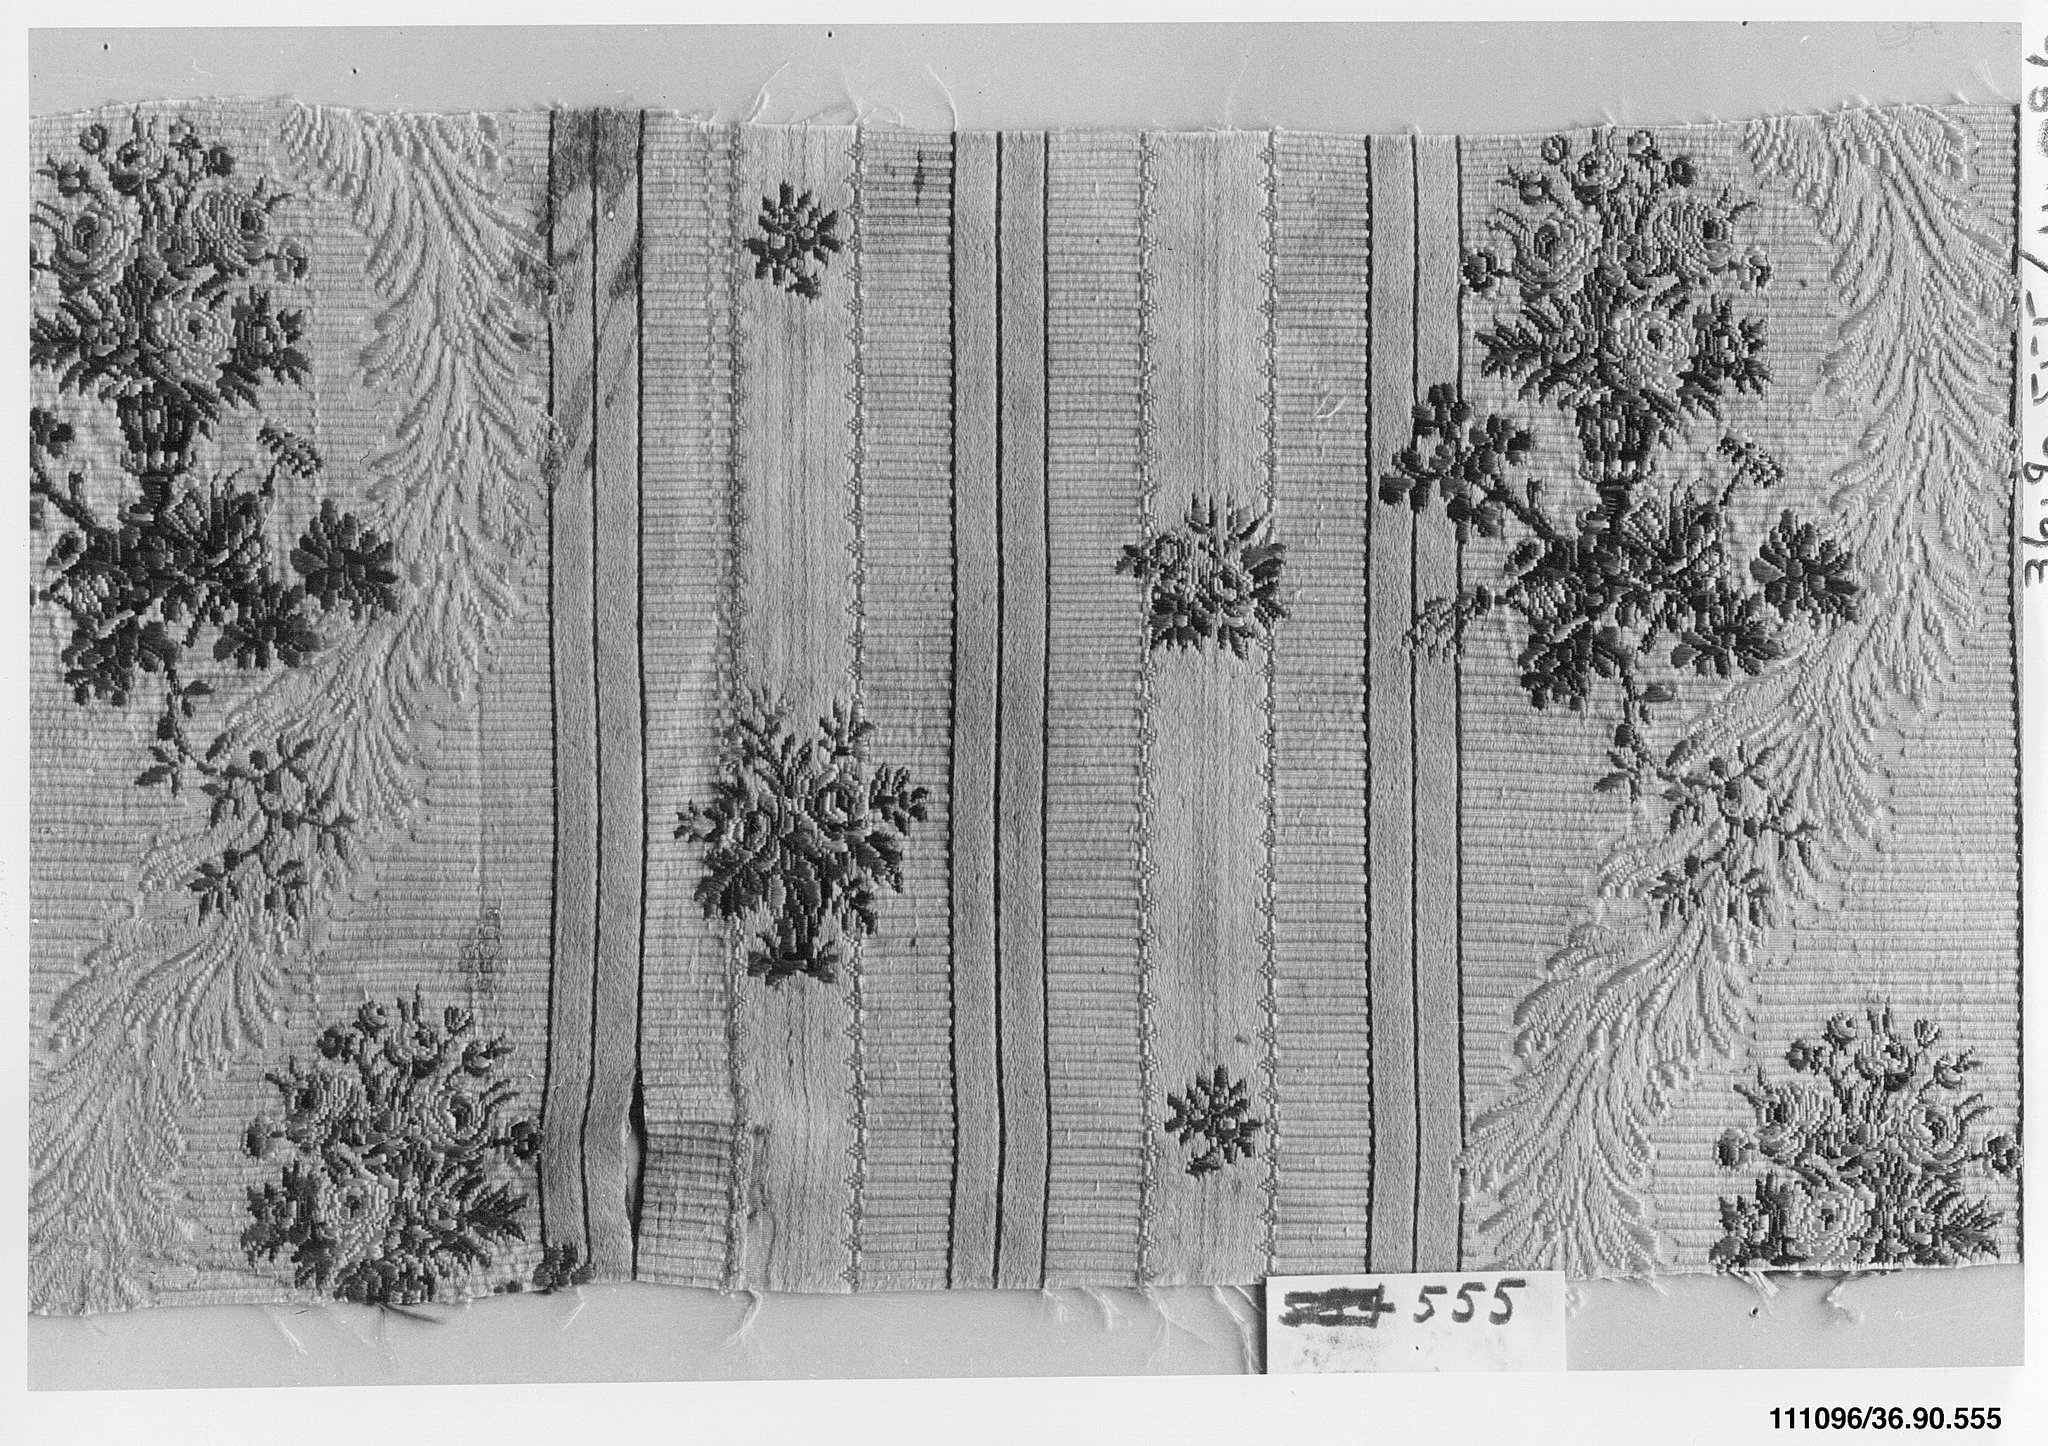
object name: piece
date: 1767-1800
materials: silk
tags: flowers,plants,leaves